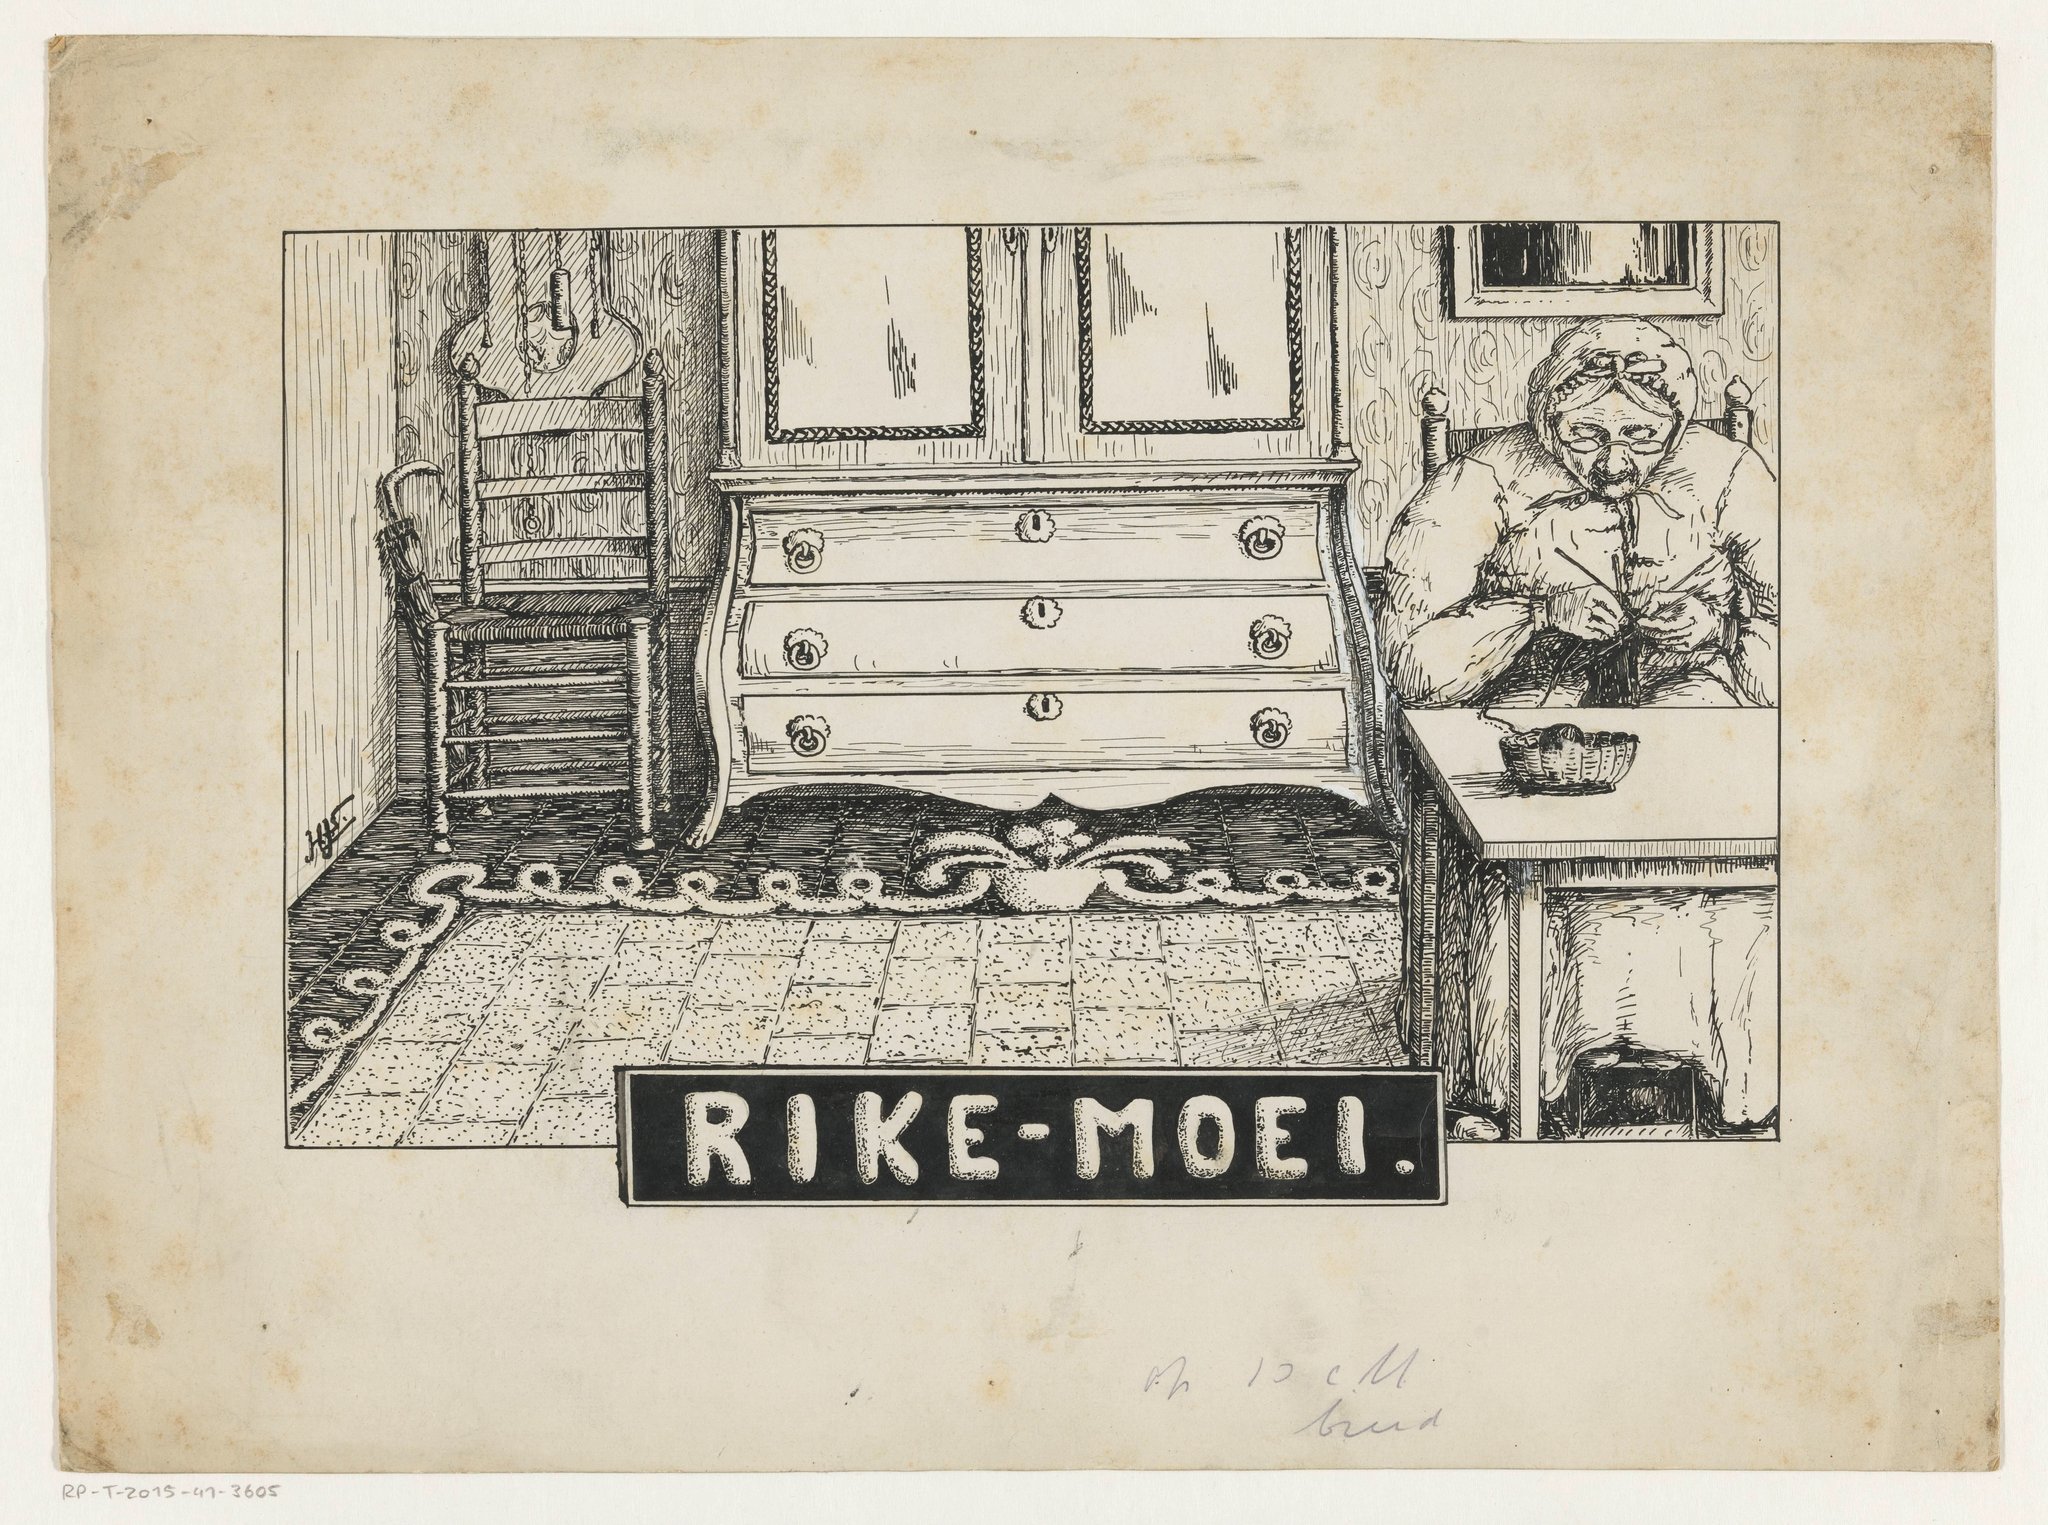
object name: boekillustratie ontwerp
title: RIKE-MOEI.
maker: Anonymous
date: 1880-1920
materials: paint, ink, paper, pencil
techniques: brush, pen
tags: old woman, knitting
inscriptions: :, collector's mark: Lugt 2228a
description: Een oude vrouw met een bril zit aan een tafel te breien. Achter haar staan twee stoelen en een kast